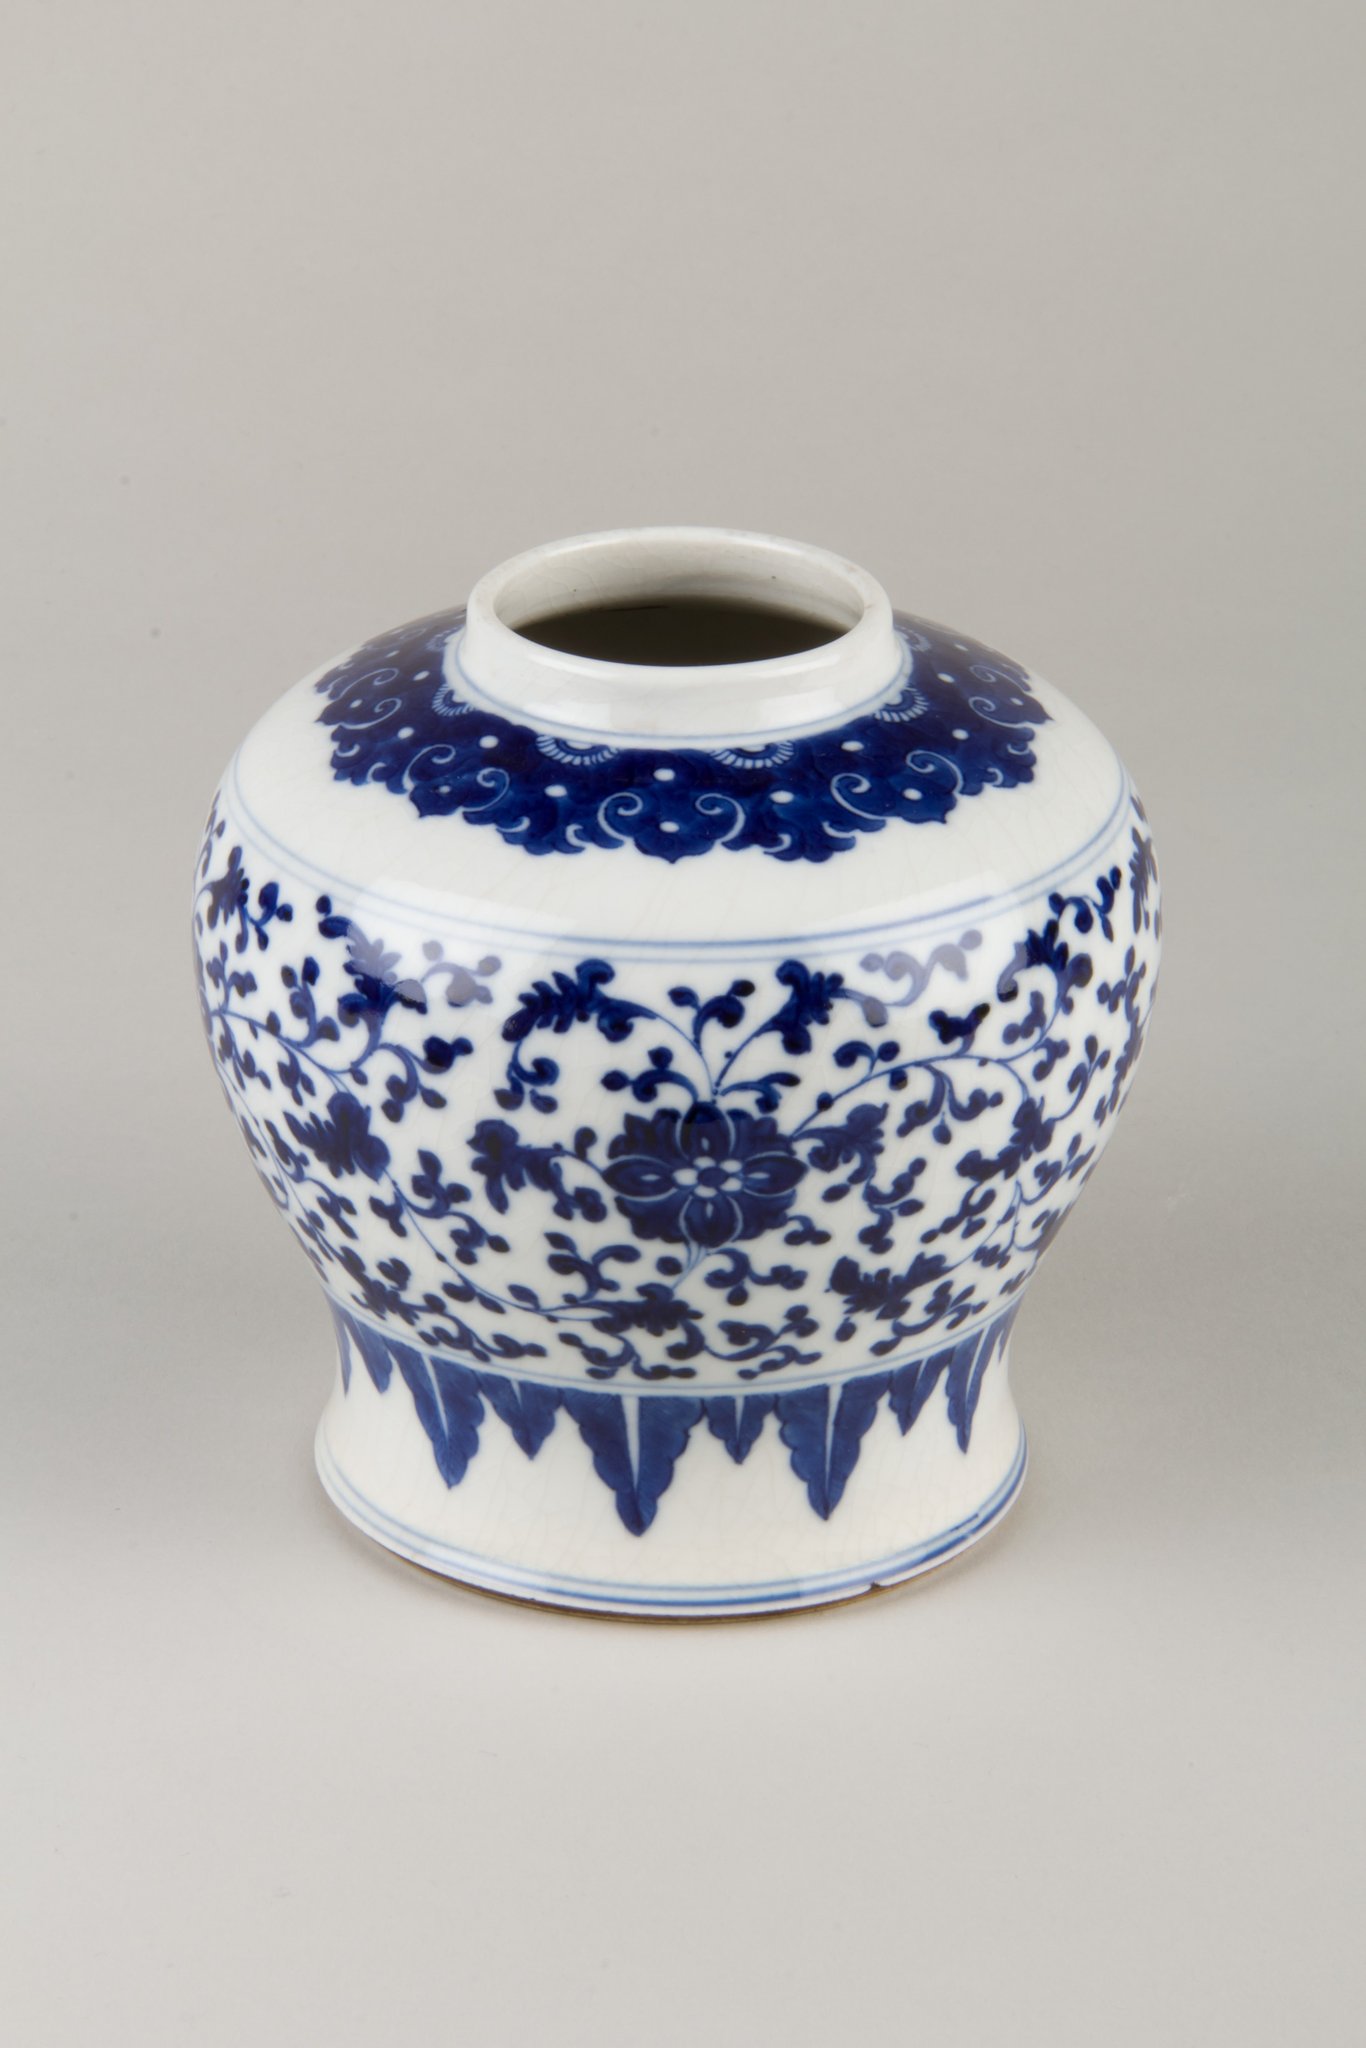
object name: jar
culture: chinese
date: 1736-1795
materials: glaze, porcelain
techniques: underglaze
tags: flowers